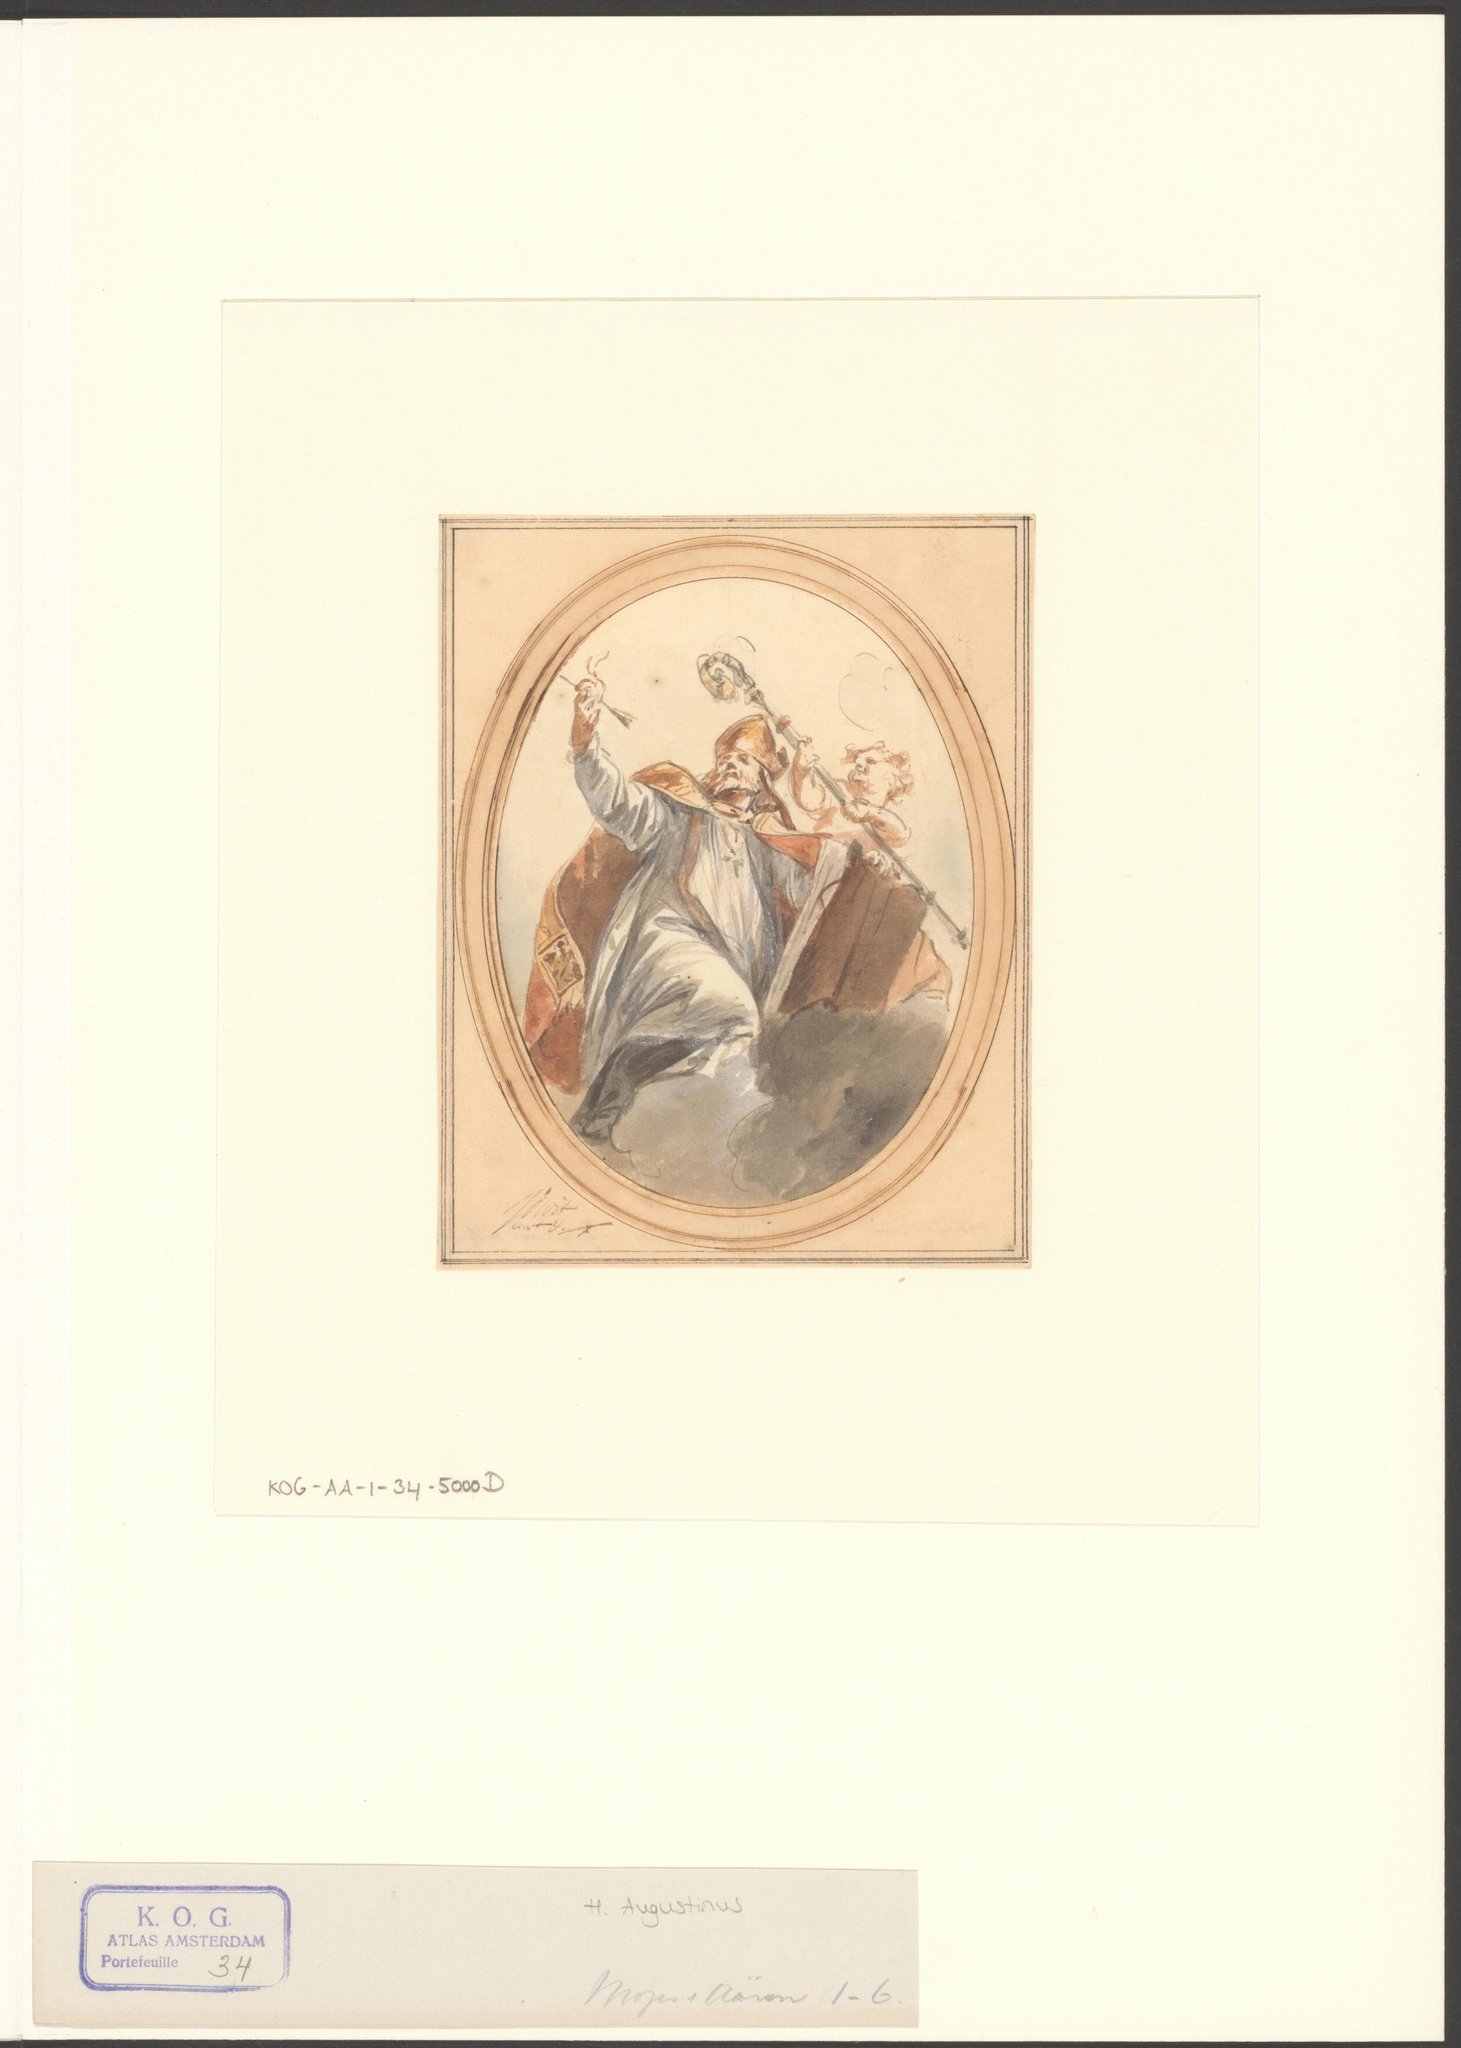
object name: drawing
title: Compositie, mogelijk het plafond van de Mozes en Aäronkerk met de heilige Augustinus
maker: jacob de wit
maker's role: draughtsman, painter, print maker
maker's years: 1695-1754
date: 1705-1754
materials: paint, ink, paper, pencil, watercolor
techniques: brush, pen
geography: amsterdam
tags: augustine, bishop of hippo; possible attributes: arrows piercing his breast, book, child with spoon, flaming heart, heart (pierced with arrows), pen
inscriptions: signature: ‘JdWit inv’, collector's mark: ‘34’ Lugt 1641b, inscription: ‘voorden eerwd paetter J raedemacker opsijn [...]d. biblio’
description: Onderwerpsrubriek binnen de Atlas Amsterdam: Begijnhof, t/m Petrus en Paulus.